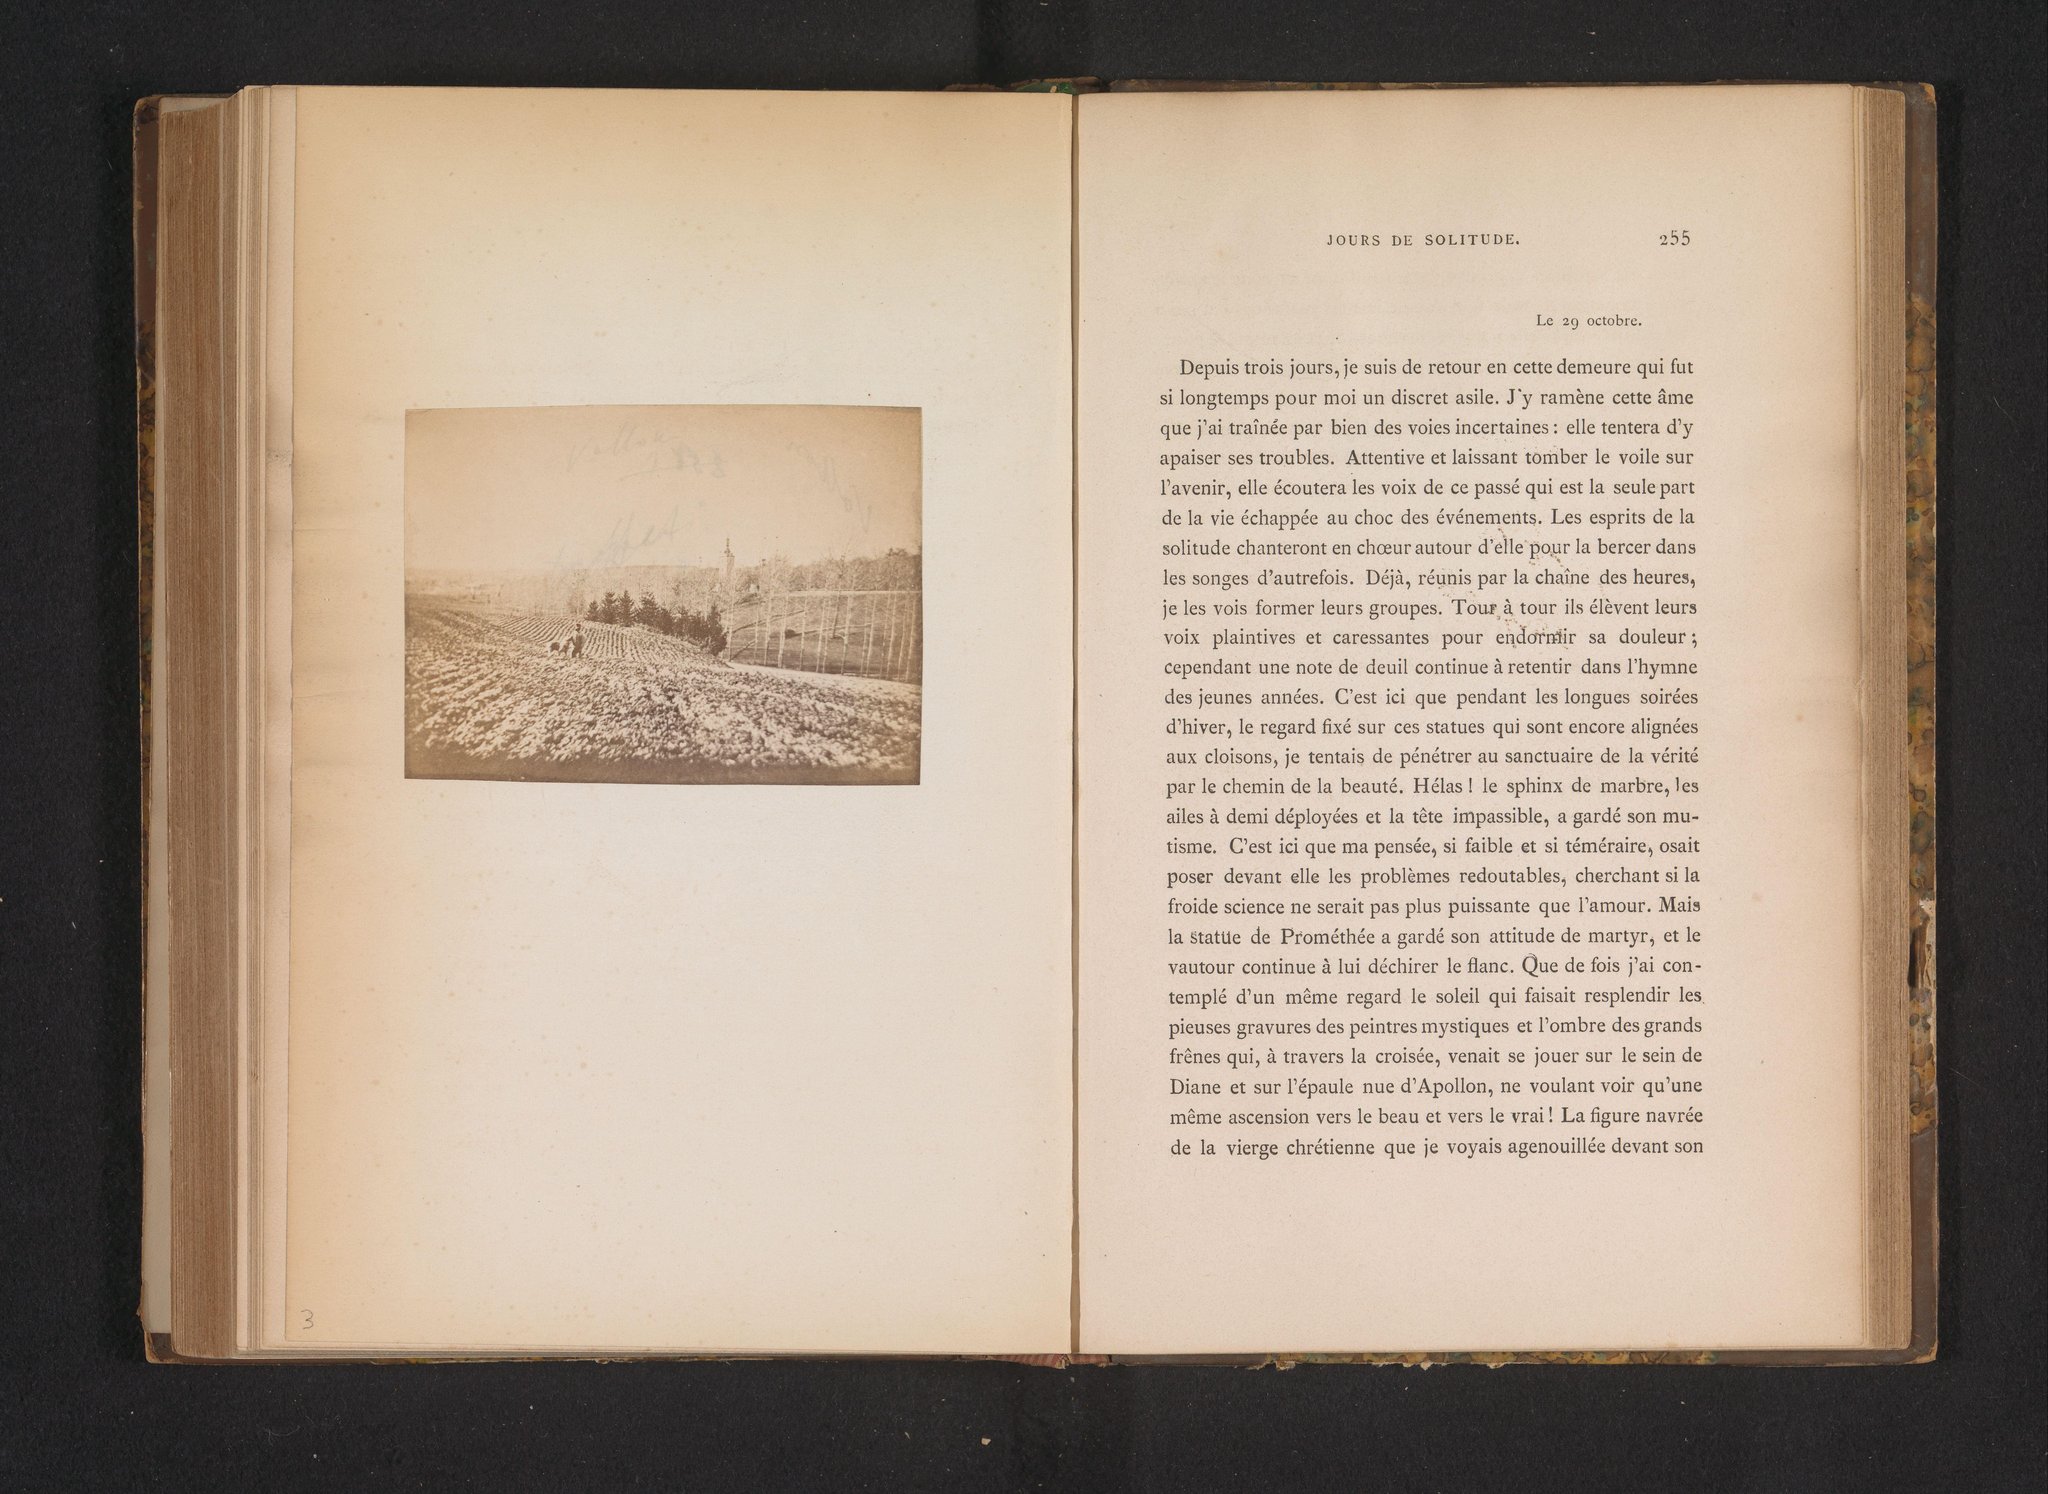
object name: photograph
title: Gezicht op een onbekende man met een hond in een veld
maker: Anonymous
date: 1872-1877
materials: photographic support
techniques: albumen print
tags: field filled with a crop, historical persons, dog